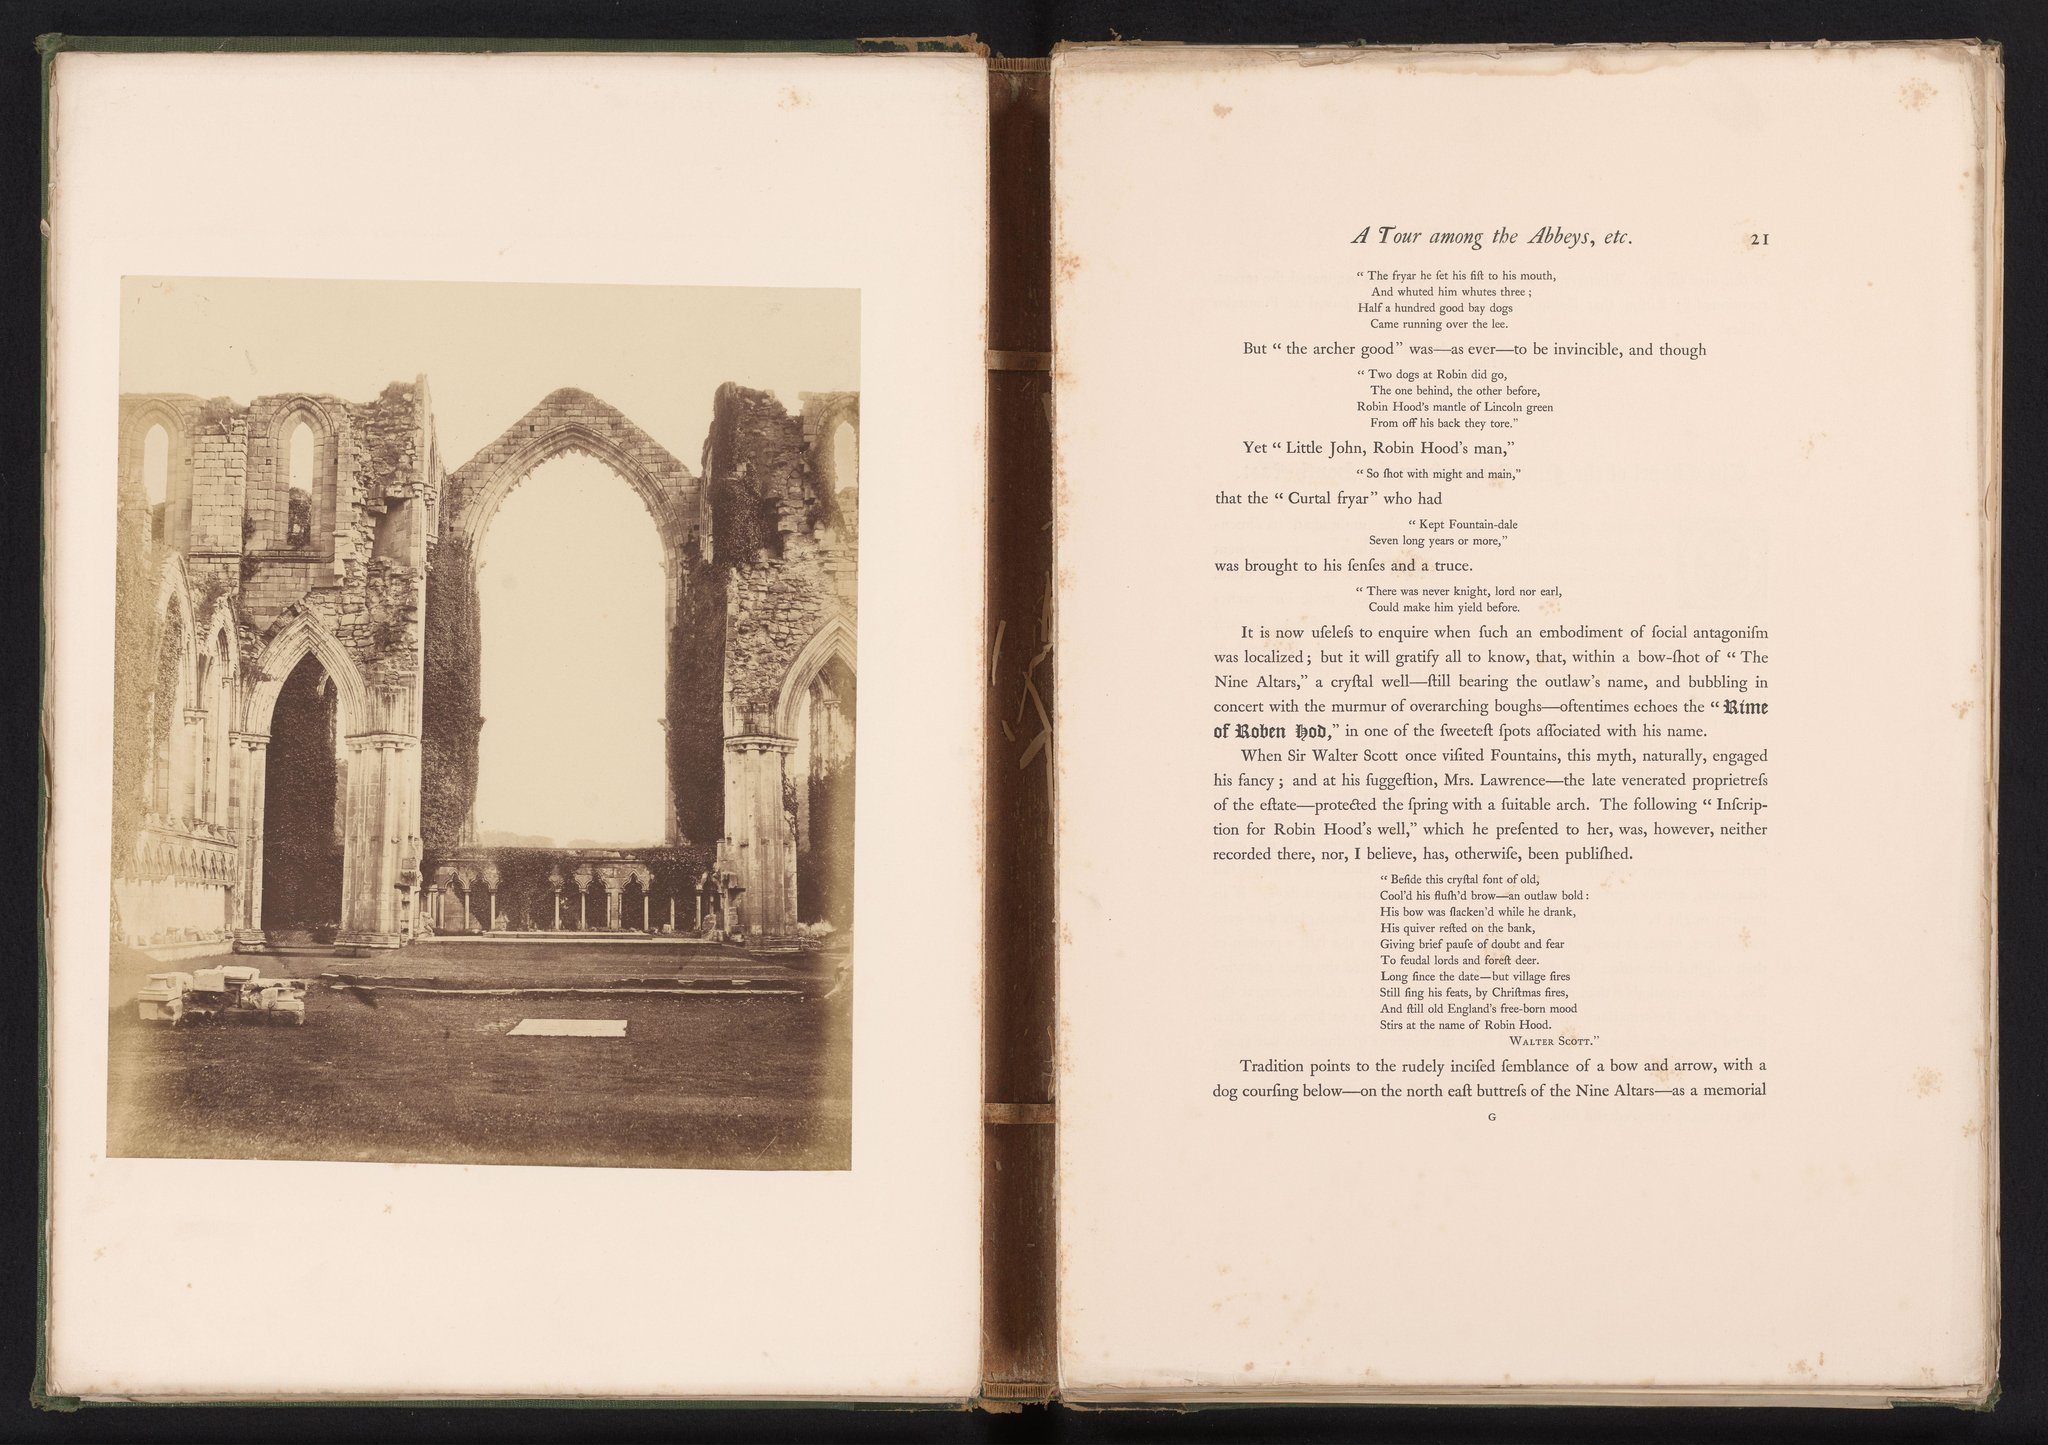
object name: page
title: Interieur van de Chapel of the Nine Altars bij de Fountains Abbey nabij Ripon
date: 1851-1856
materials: photographic support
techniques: albumen print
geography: fountains abbey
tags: ruin of church, monastery, etc. - qq - small church, chapel, parts of church interior: chapel